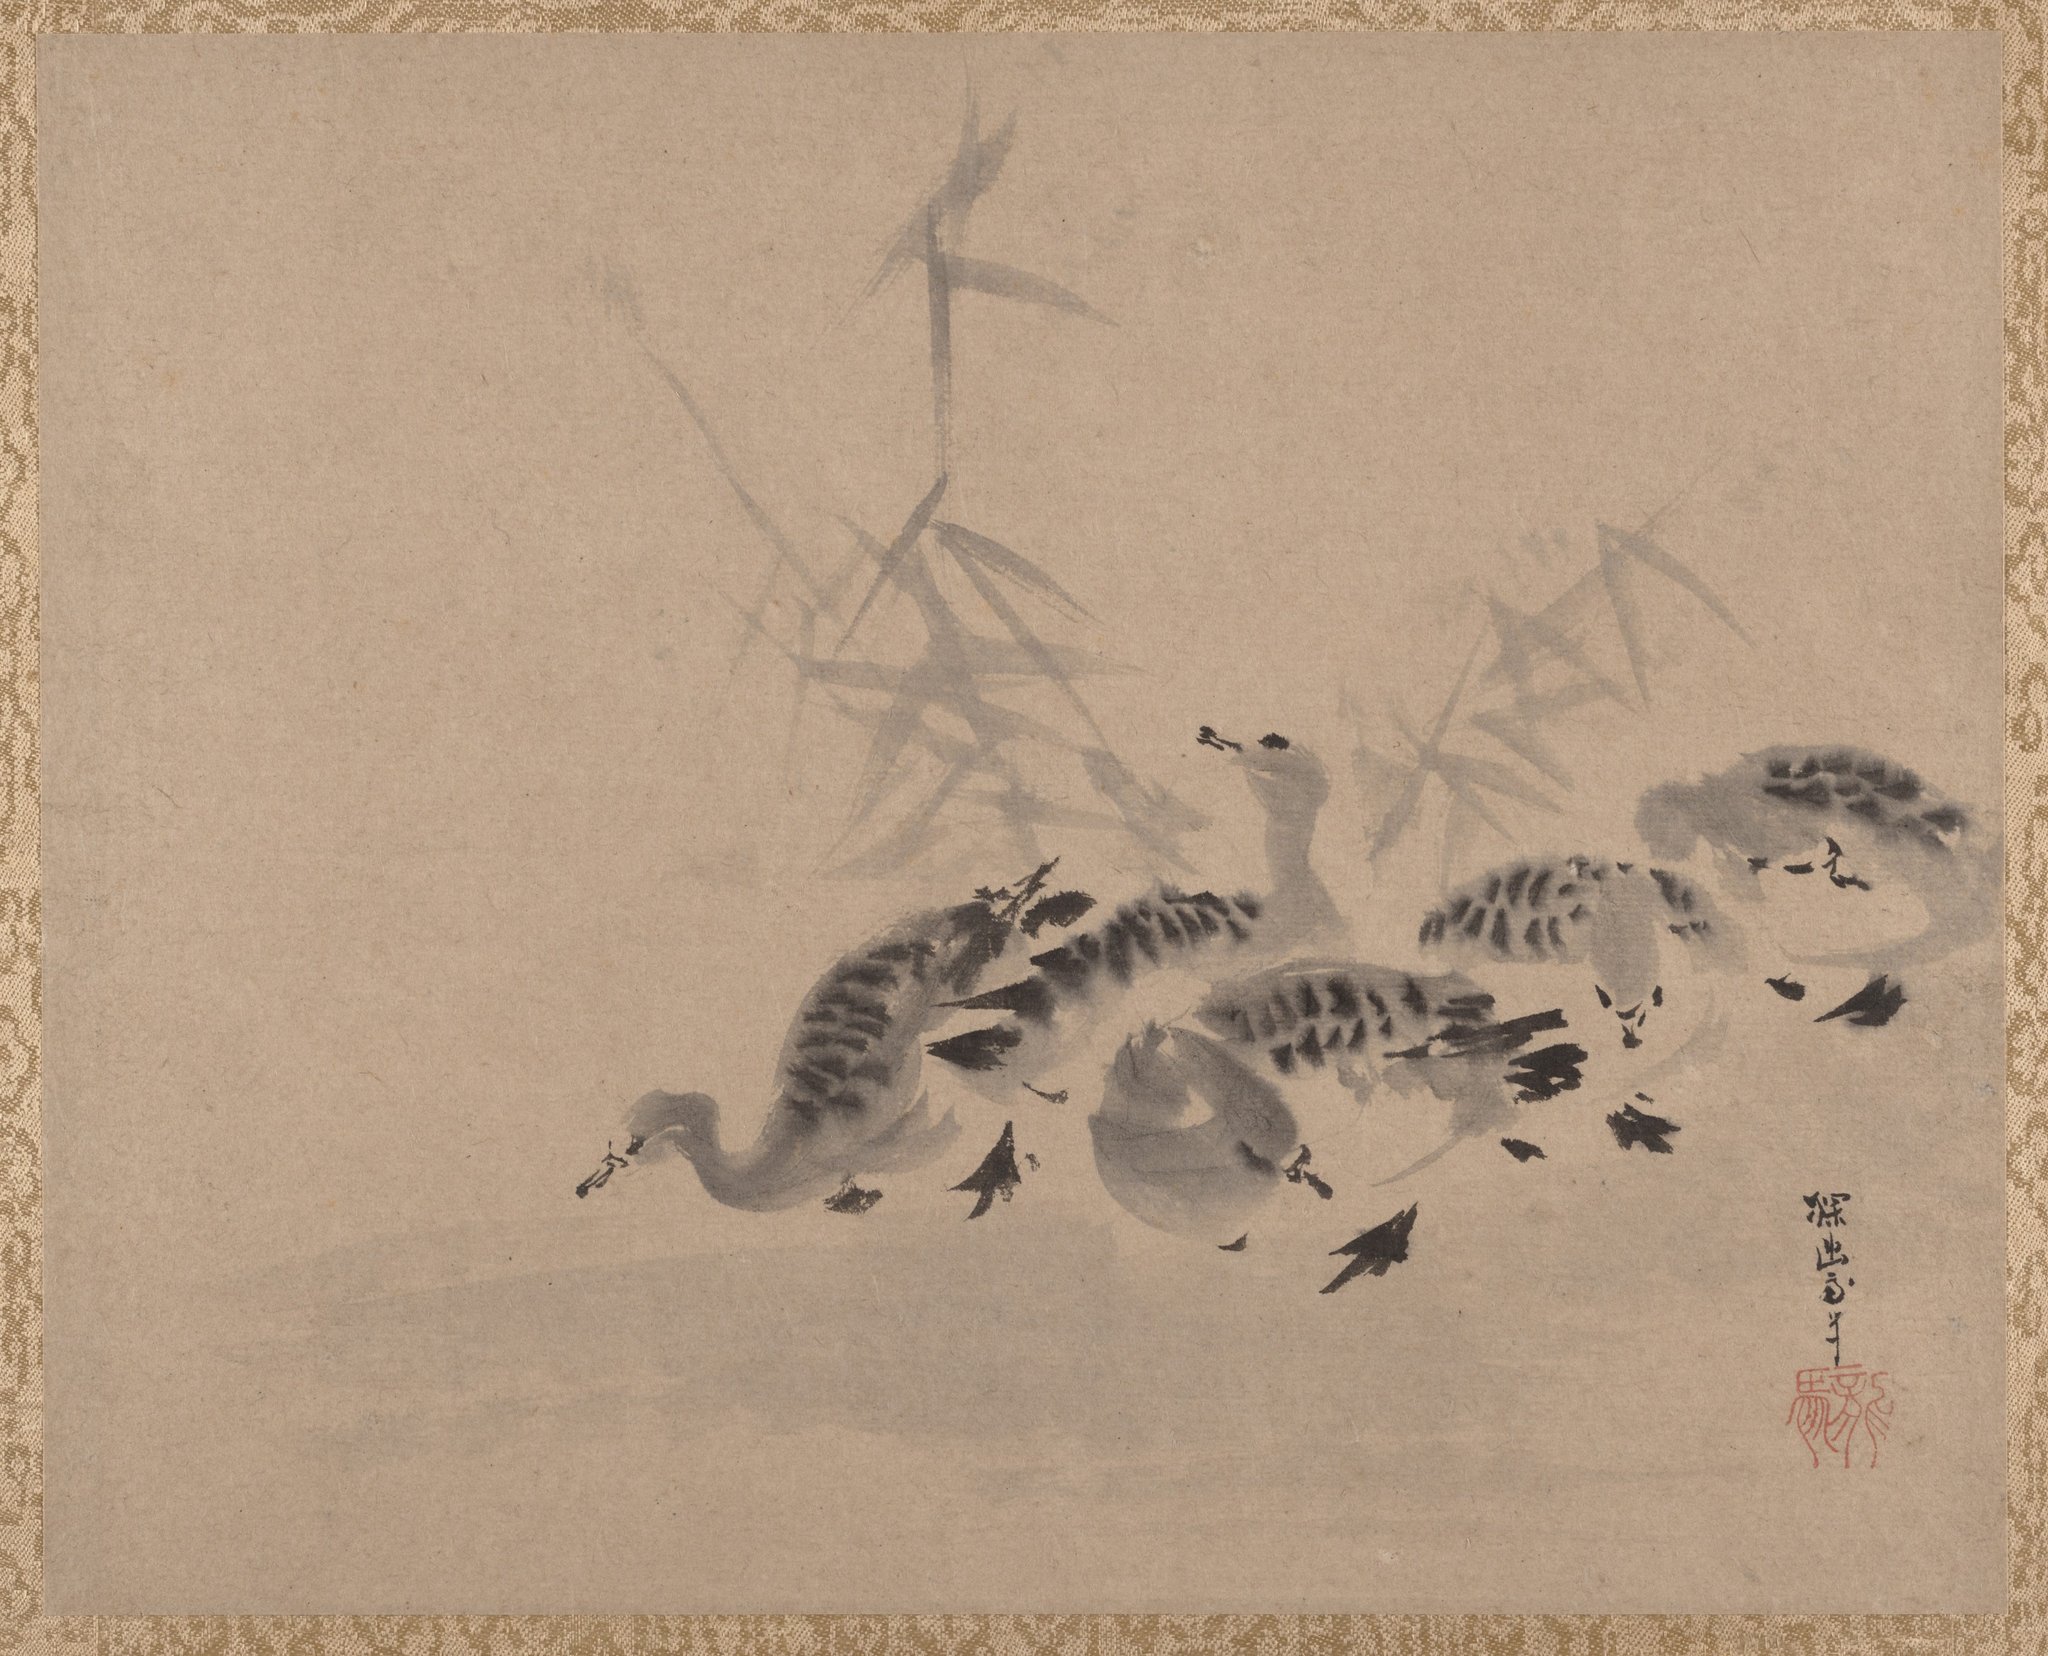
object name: album leaf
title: Ducks and Reeds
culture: japanese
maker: kano tan'yū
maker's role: artist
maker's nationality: japanese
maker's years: 1602-1674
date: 1650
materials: ink, paper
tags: ducks